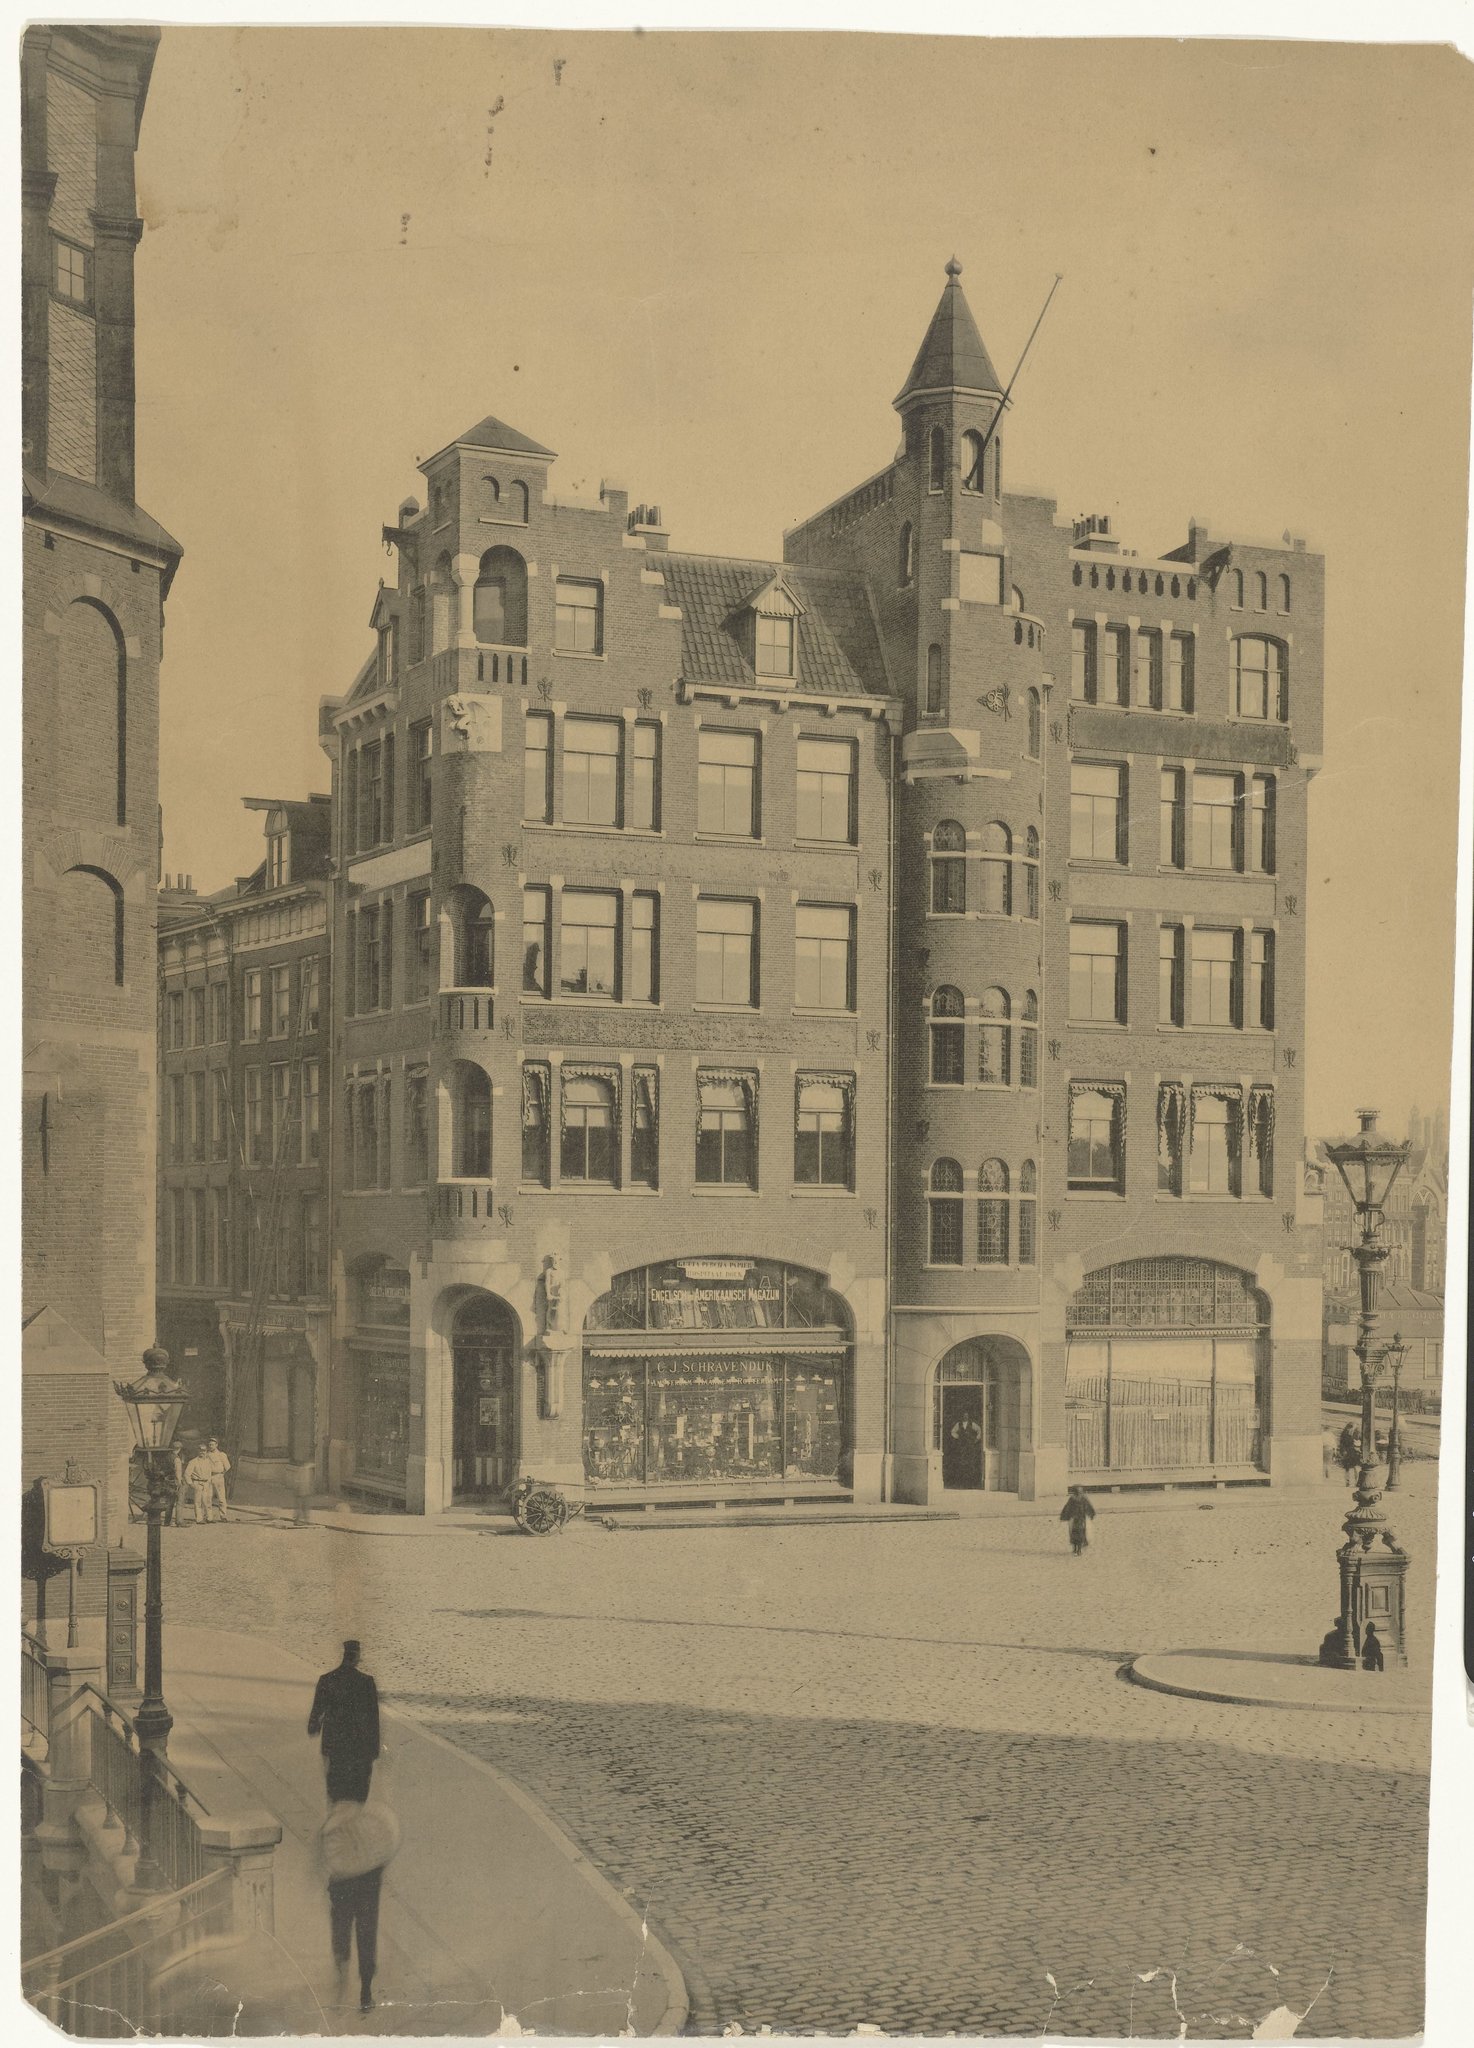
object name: photograph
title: Panden aan het Muntplein in Amsterdam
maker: Anonymous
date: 1880-1920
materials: paper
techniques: photograph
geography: amsterdam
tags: city-view in general; 'veduta'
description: Muntplein 2-4. Onderin het pand links is het Engelsch/Amerikaansch Magazijn van C.J. Schravendijk gevestigd. Links de Munttoren.